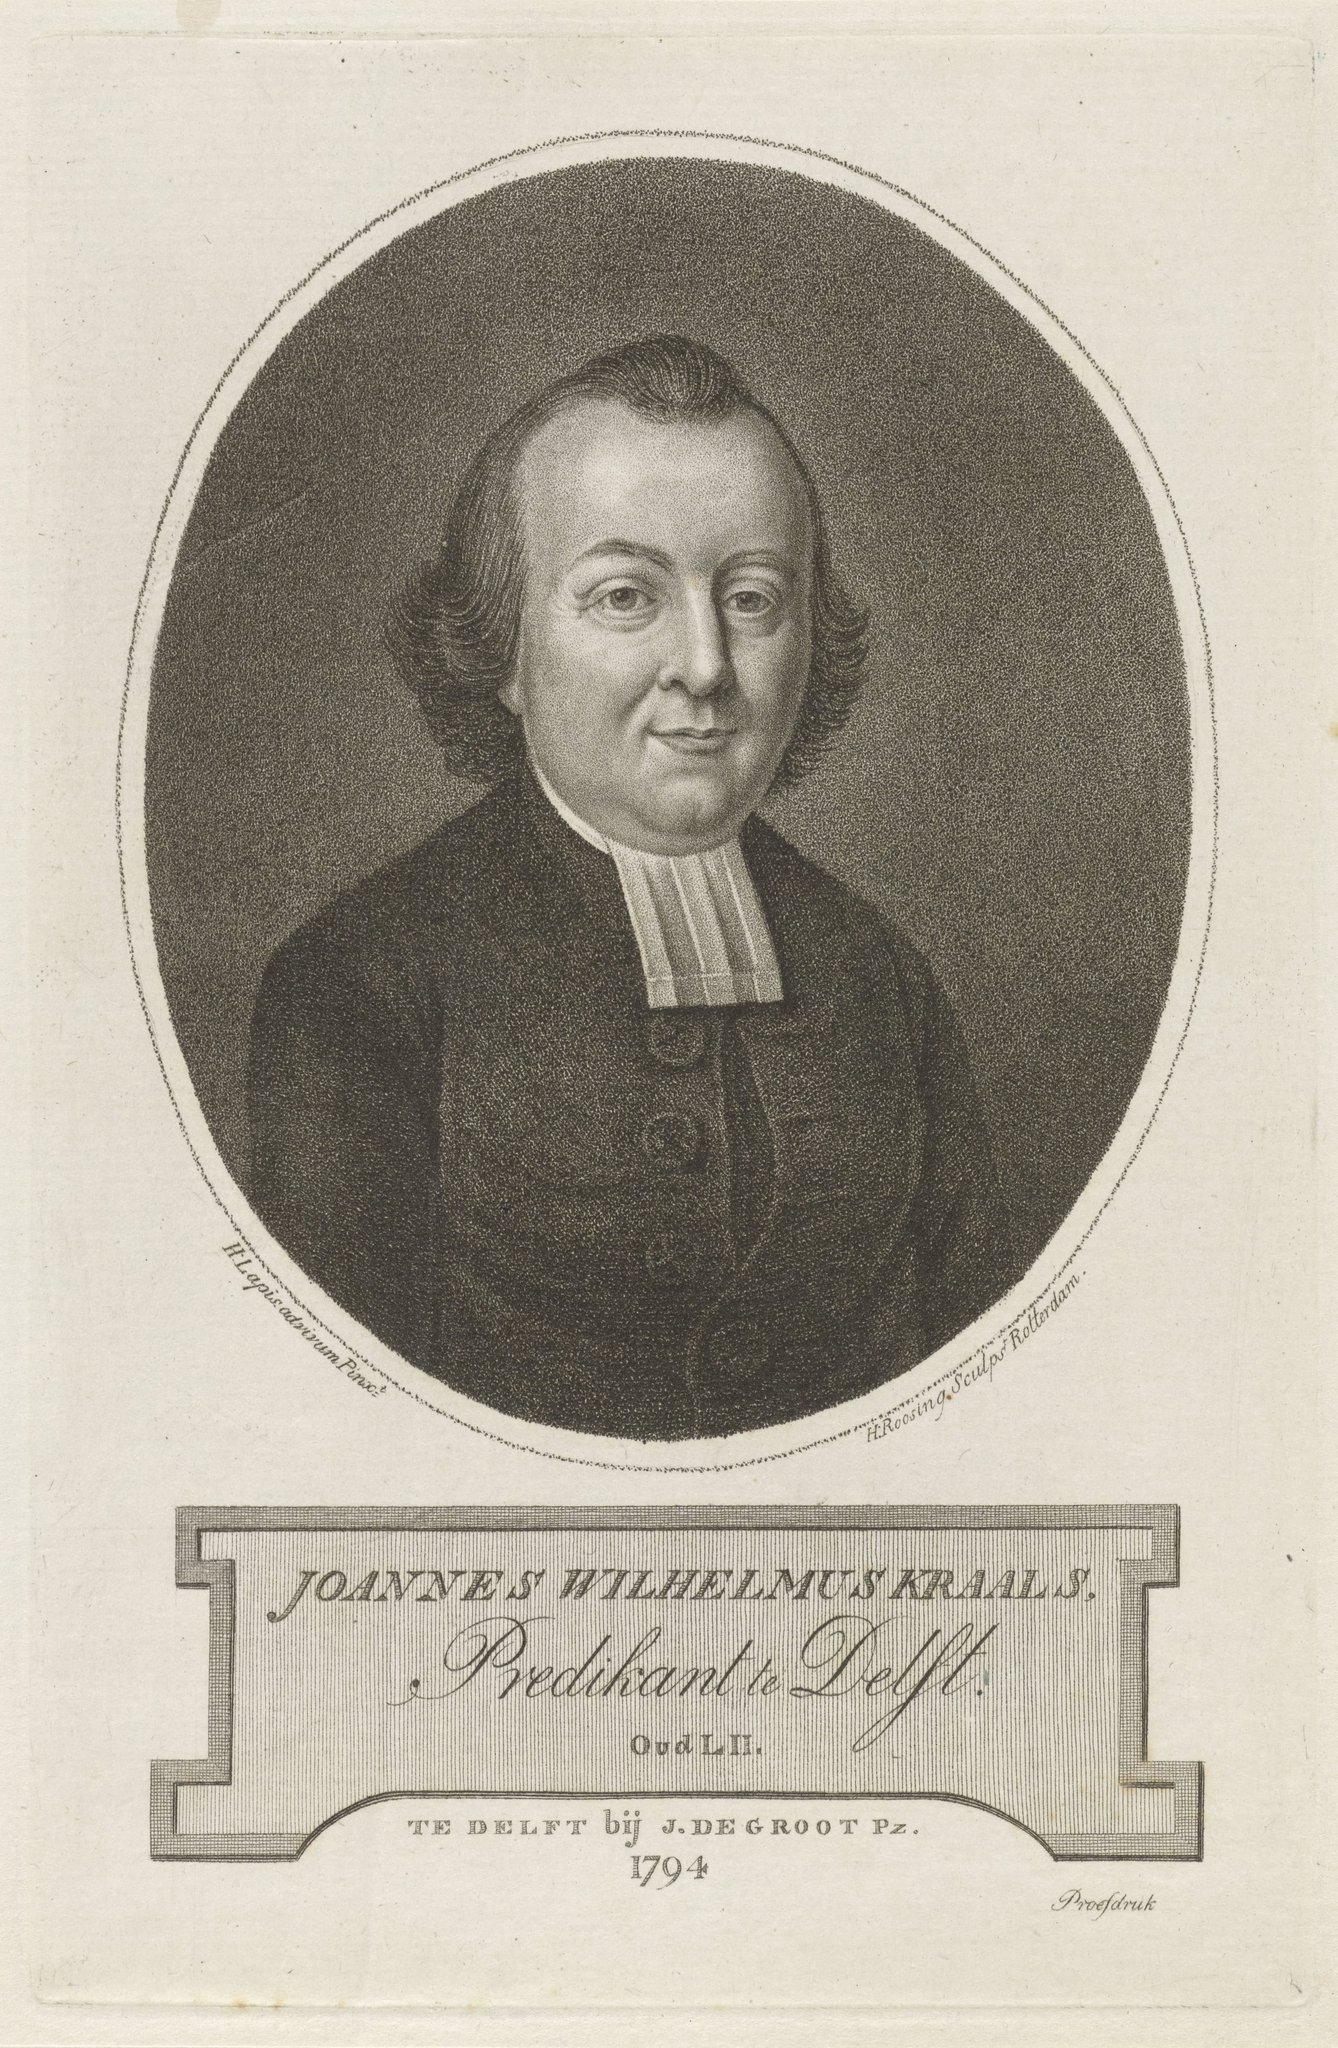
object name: print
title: Portret van Joannes Wilhelmus Kraals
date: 1794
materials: paper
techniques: engraving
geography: rotterdam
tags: joannes wilhelmus kraals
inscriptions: collector's mark: Lugt 2228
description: Portret van Joannes Wilhelmus Kraals op 52-jarige leeftijd. Vanaf 1782 was hij predikant te Delft.